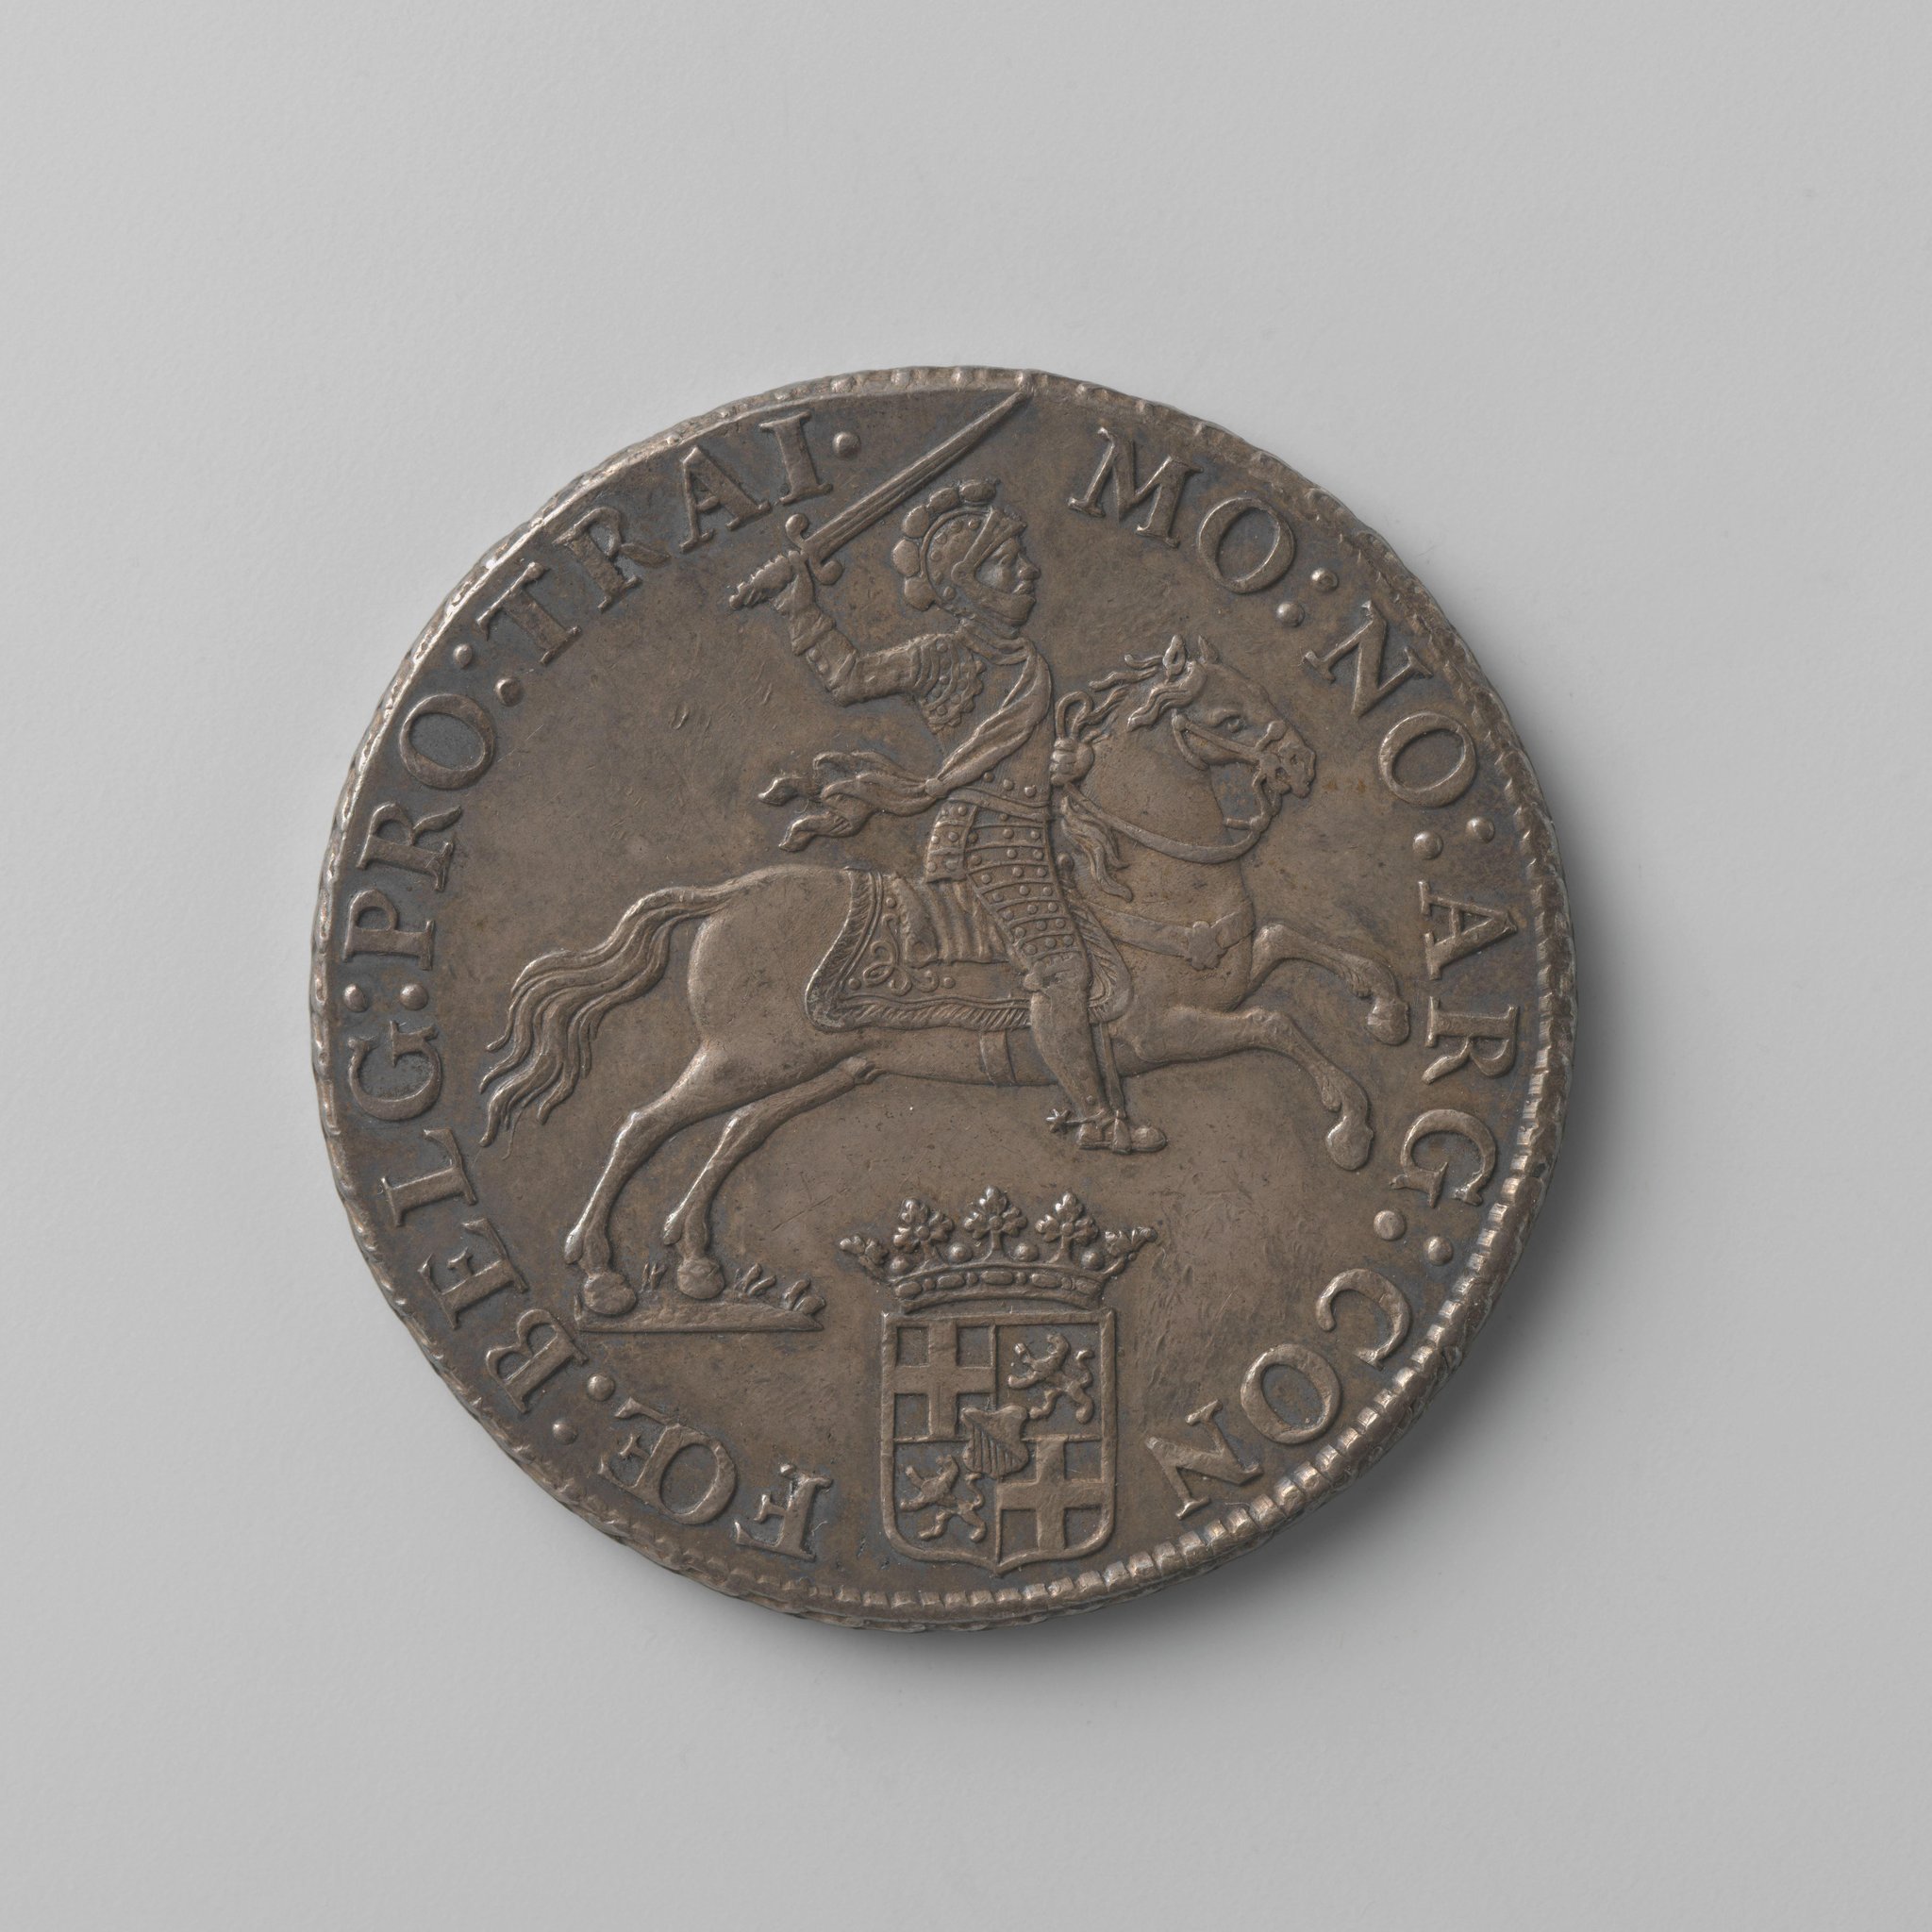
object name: coin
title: Utrechtse zilveren rijder, 1759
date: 1759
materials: silver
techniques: striking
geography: utrecht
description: Zilveren munt. Voorzijde: ridder te paard naar rechts met in rechterhand zwaard. Onder paard gekroond wapenschild van Utrecht. Keerzijde: door twee gekroonde leeuwen gehouden generaliteitswapenschild. Daaronder in cartouche jaartal. Bloemrand.